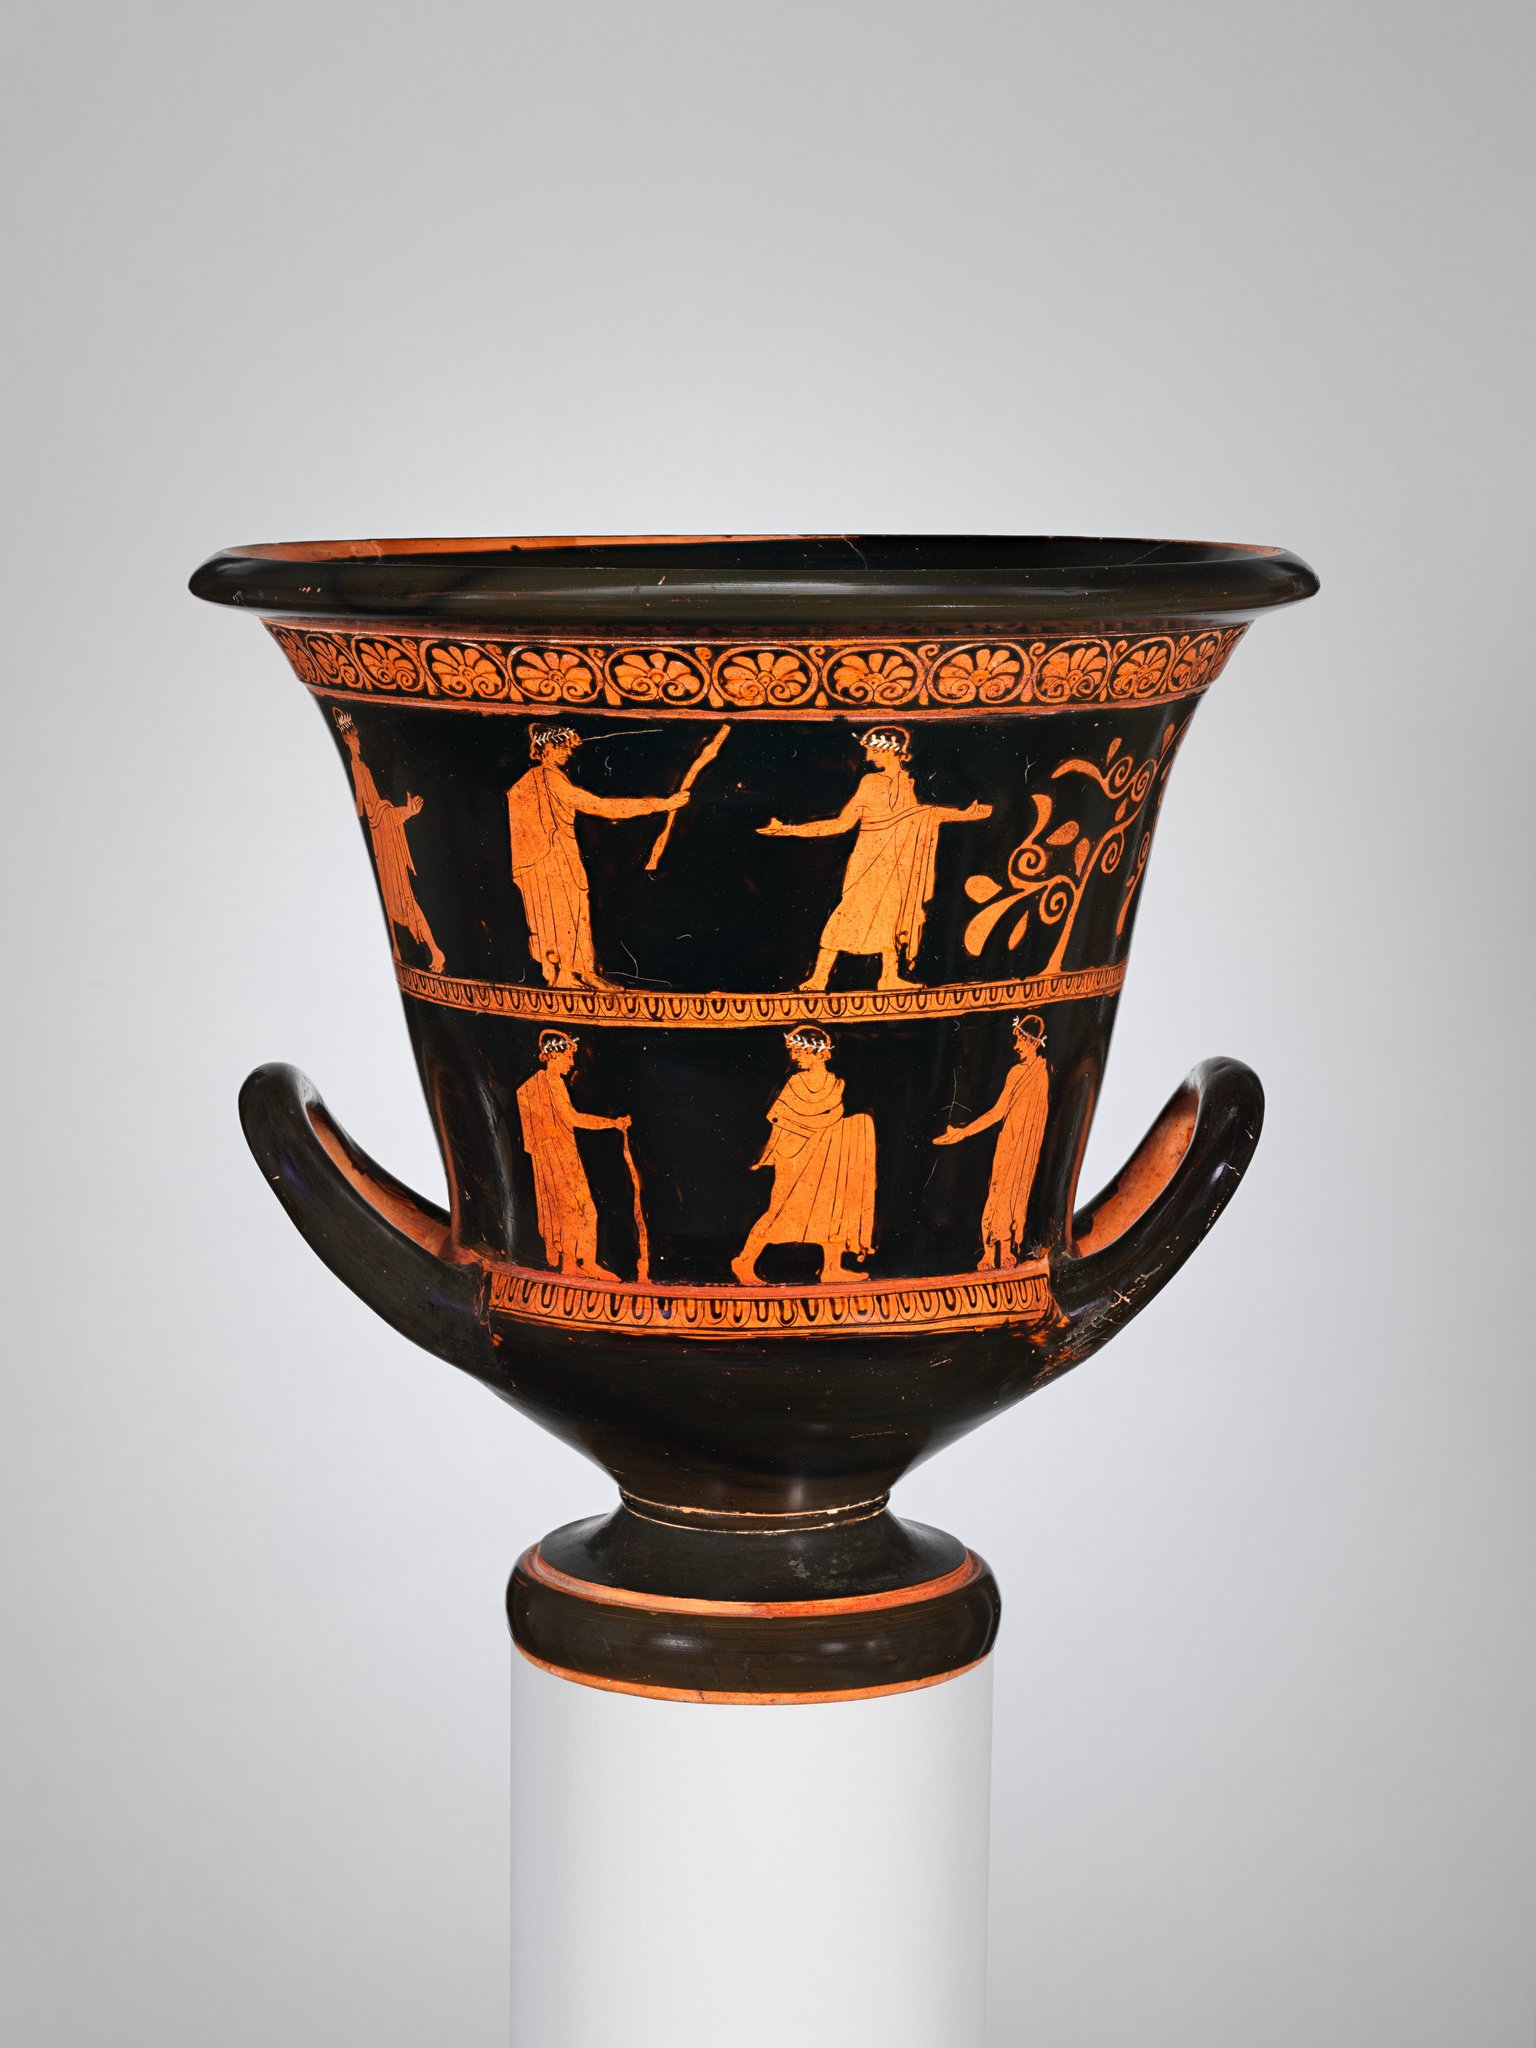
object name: calyx krater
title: Calyx-krater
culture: greek, attic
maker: douris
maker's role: artist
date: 460 BCE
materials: terracotta